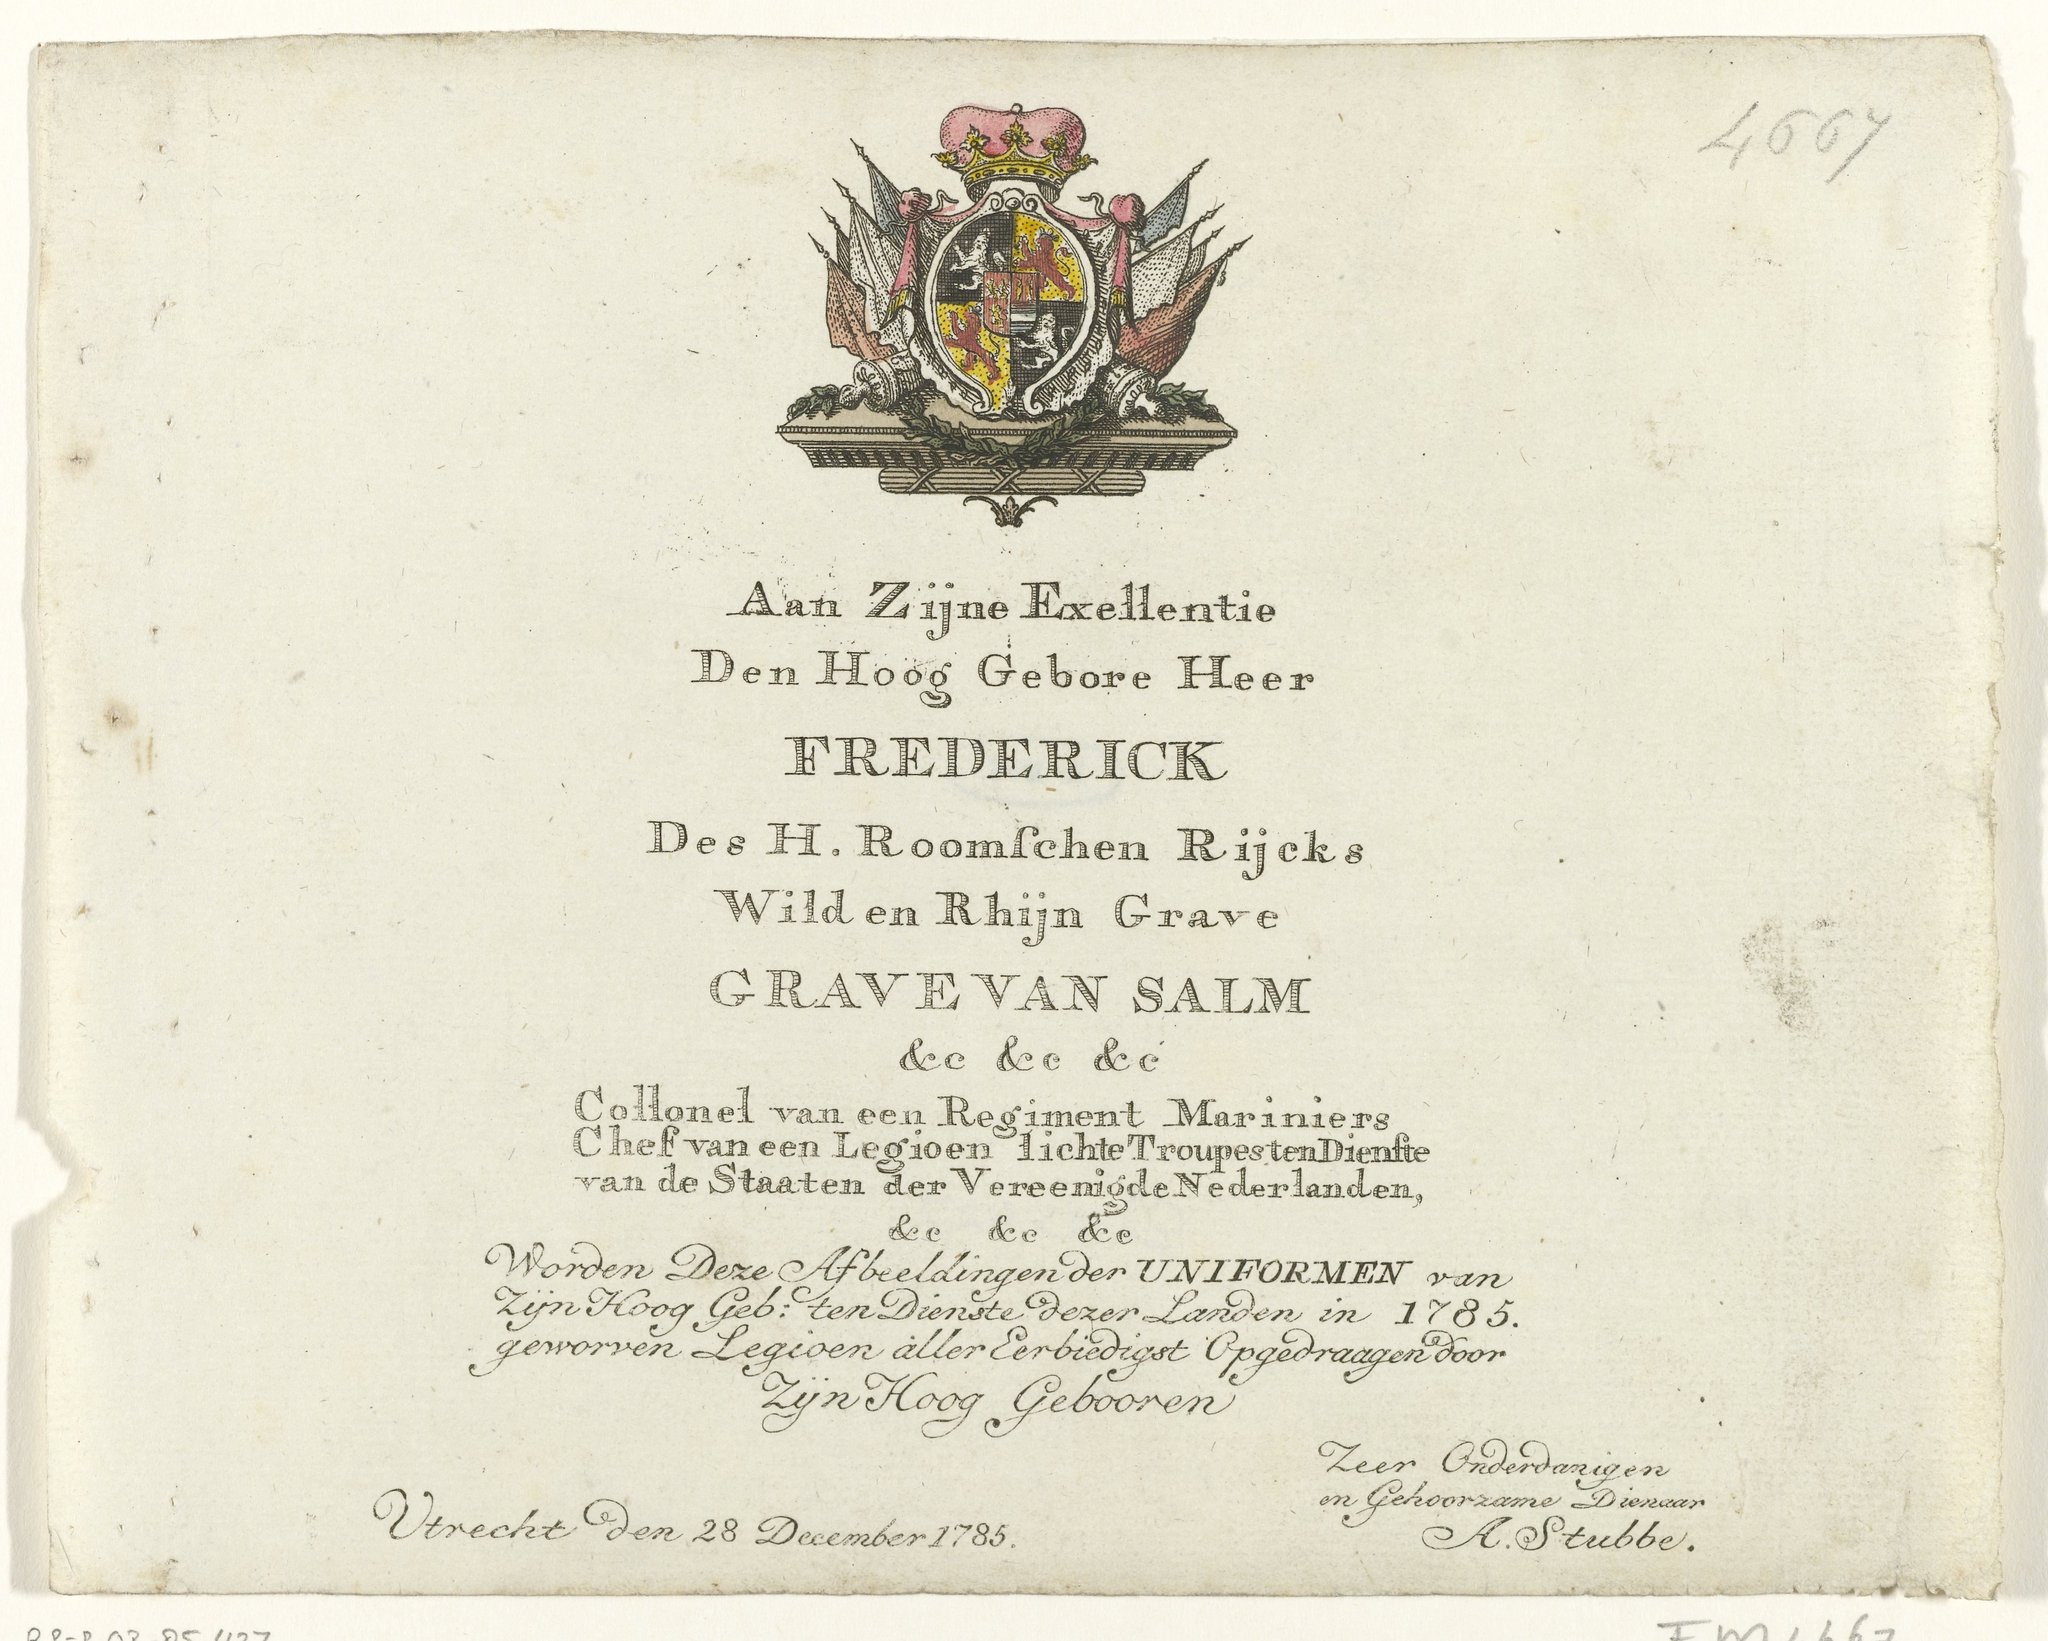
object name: print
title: Uniformen van het legioen van de Rijngraaf van Salm, 1785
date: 1785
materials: paper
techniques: etching, hand coloring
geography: utrecht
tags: rijngraaf van salm frederik iii, armorial bearing, heraldry, patriots (1780-1795)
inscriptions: collector's mark: Lugt 2228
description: Opdracht aan Frederik III, Rijngraaf van Salm, gedateerd 28 december 1785. Bovenaan het wapen van de Rijngraaf. Onderdeel van de prentserie van uniformen van het legioen van Frederik III Rijngraaf van Salm, in dienst van Republiek in 1785.